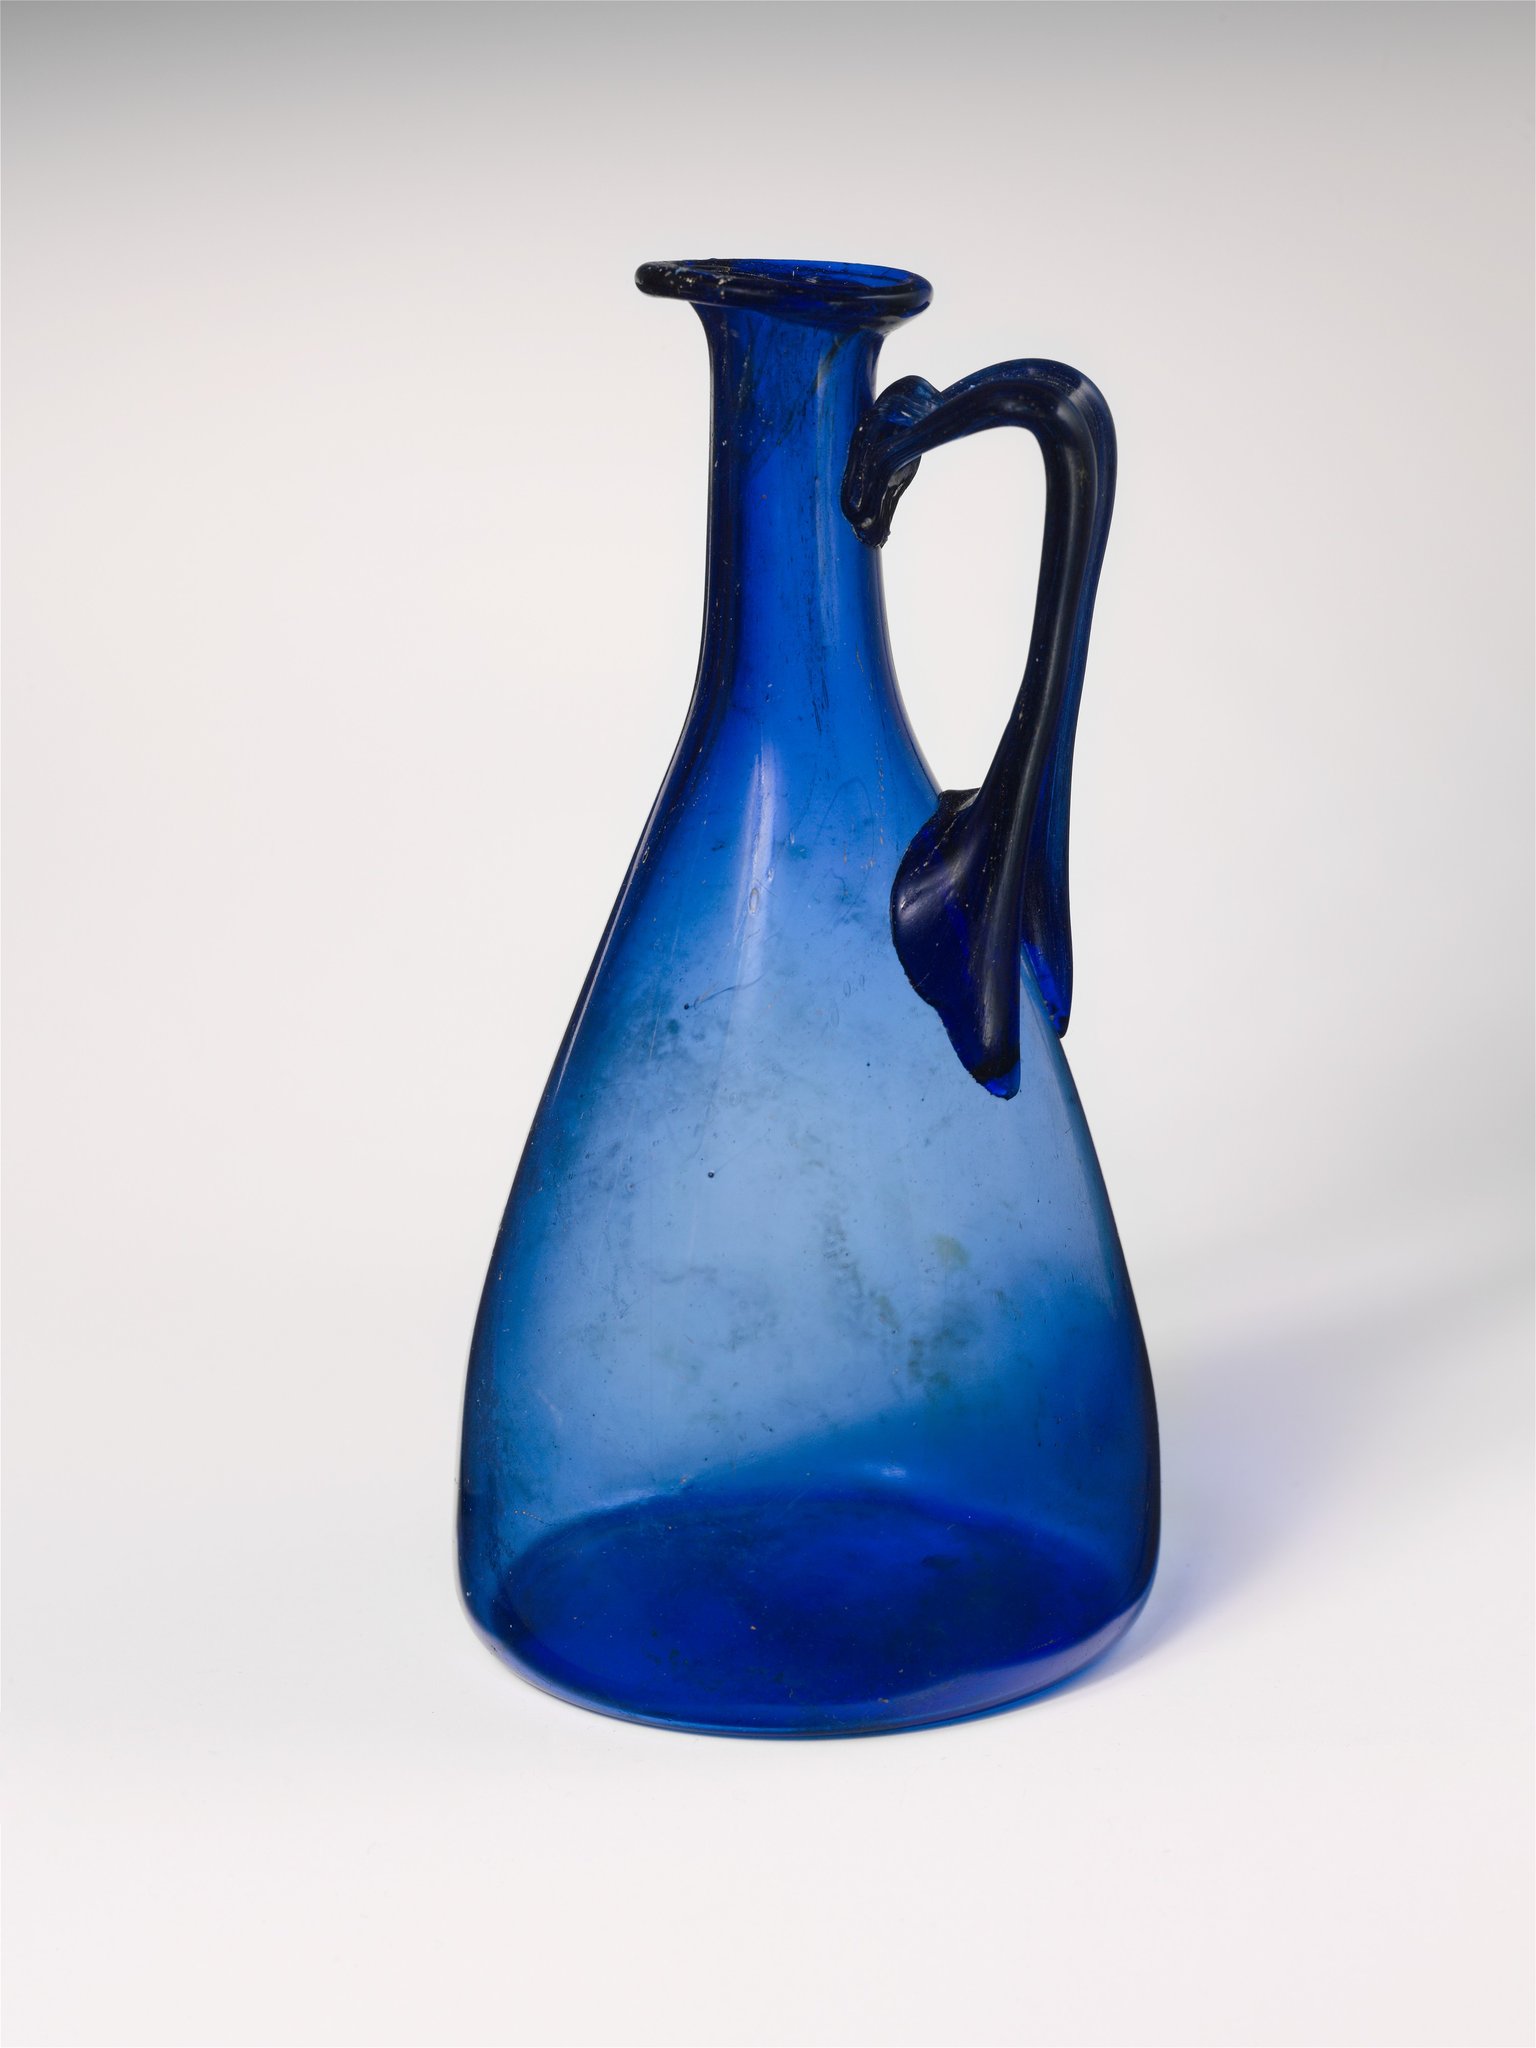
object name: jug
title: Glass jug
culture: roman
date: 1-100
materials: glass